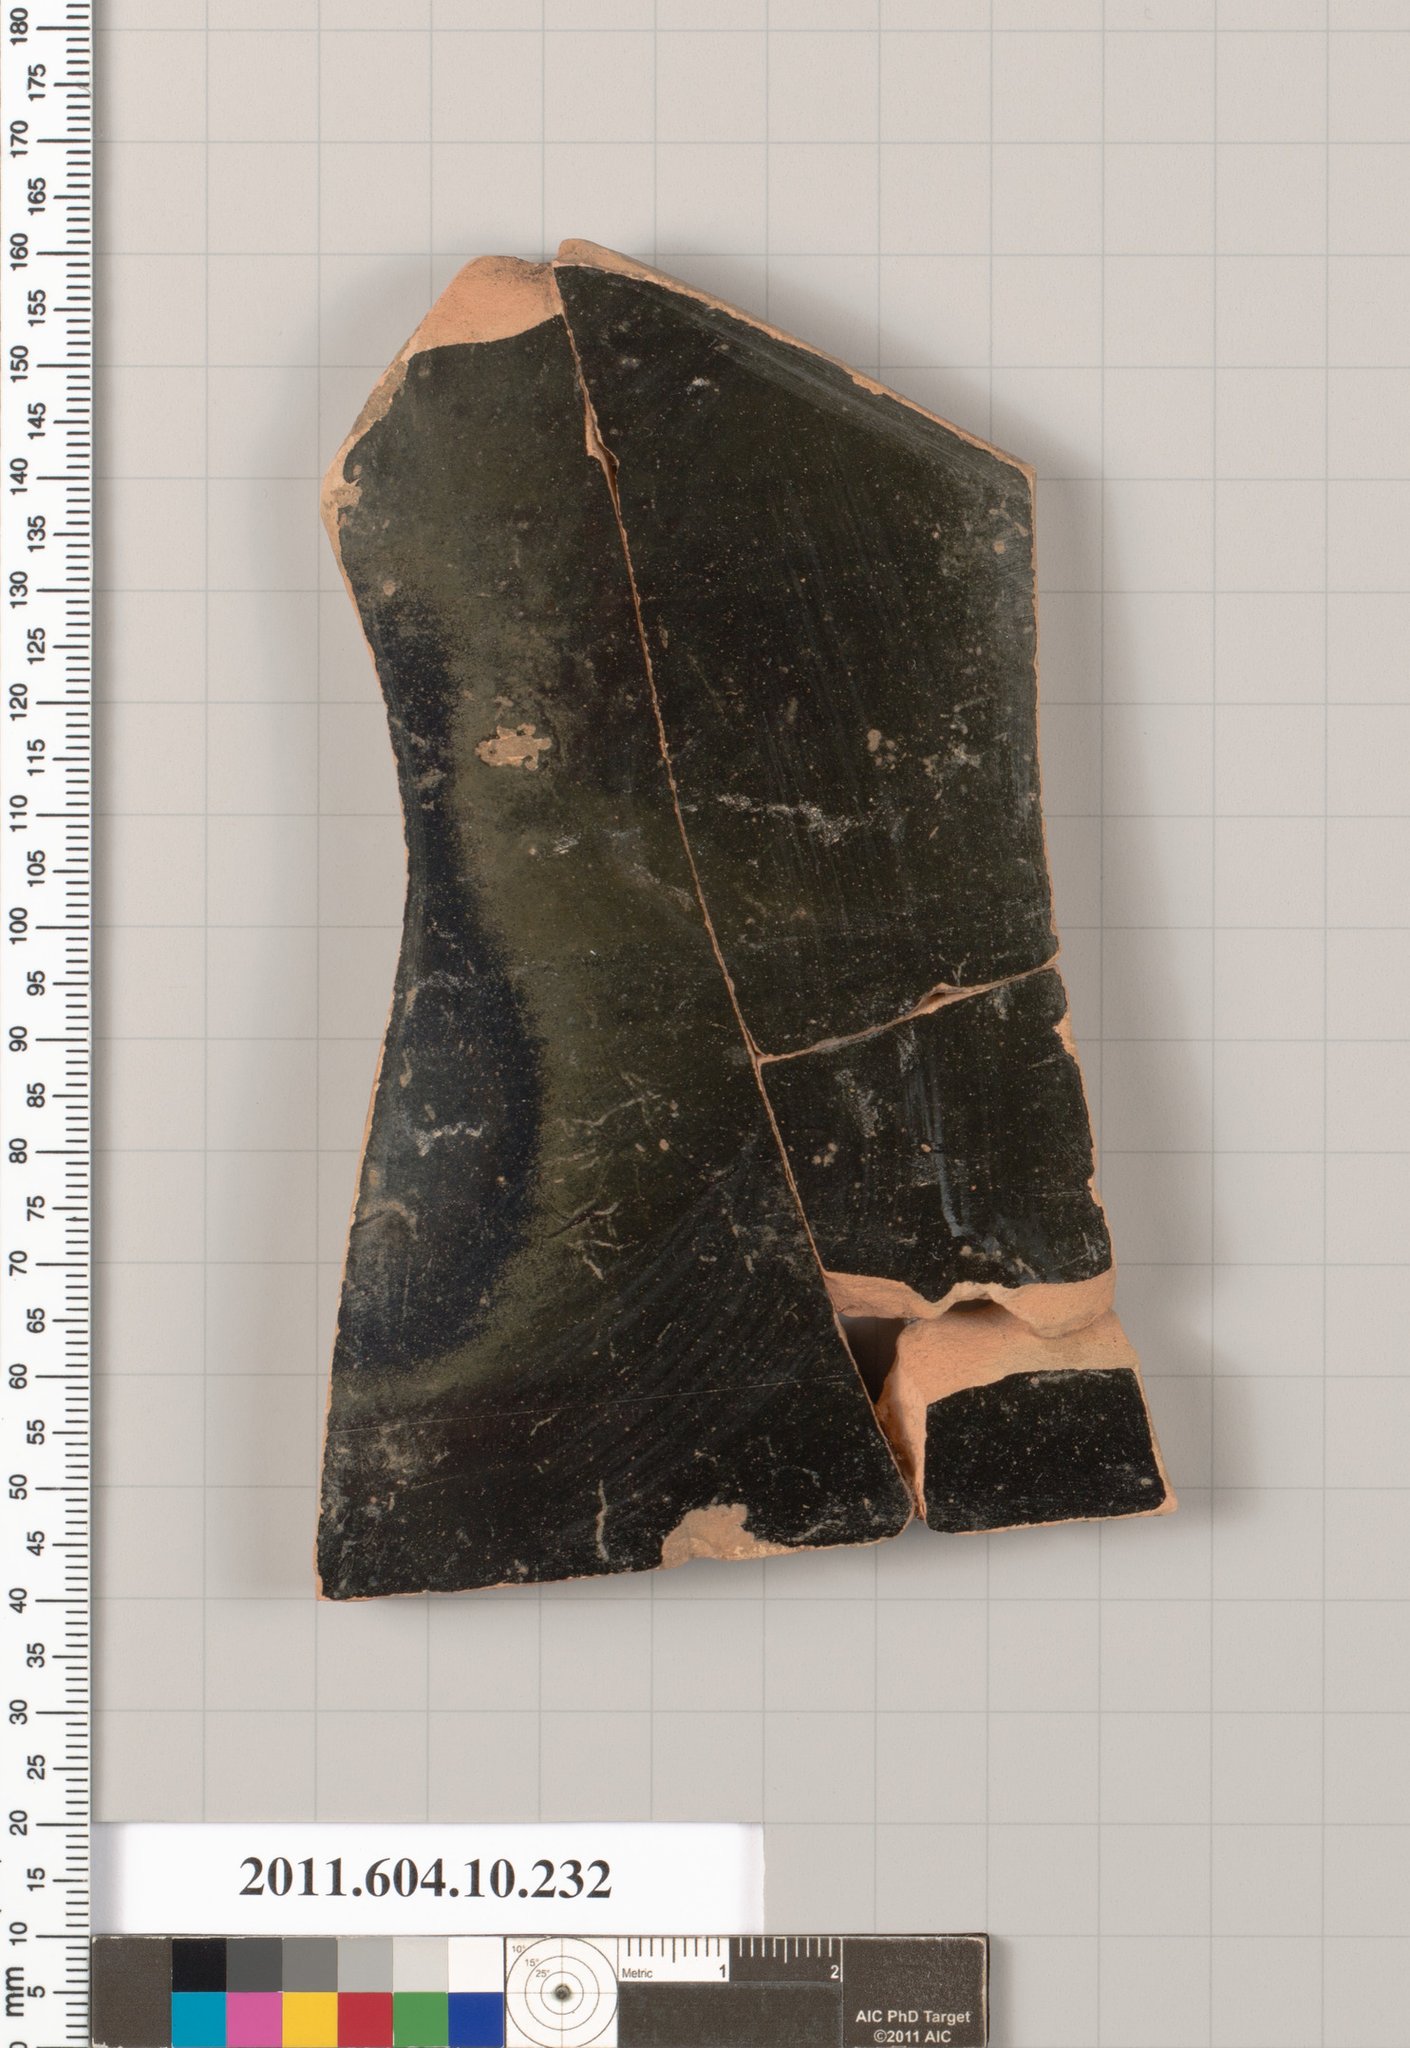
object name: krater fragment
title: Terracotta fragment of a krater (deep bowl)?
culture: etruscan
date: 601-700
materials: terracotta